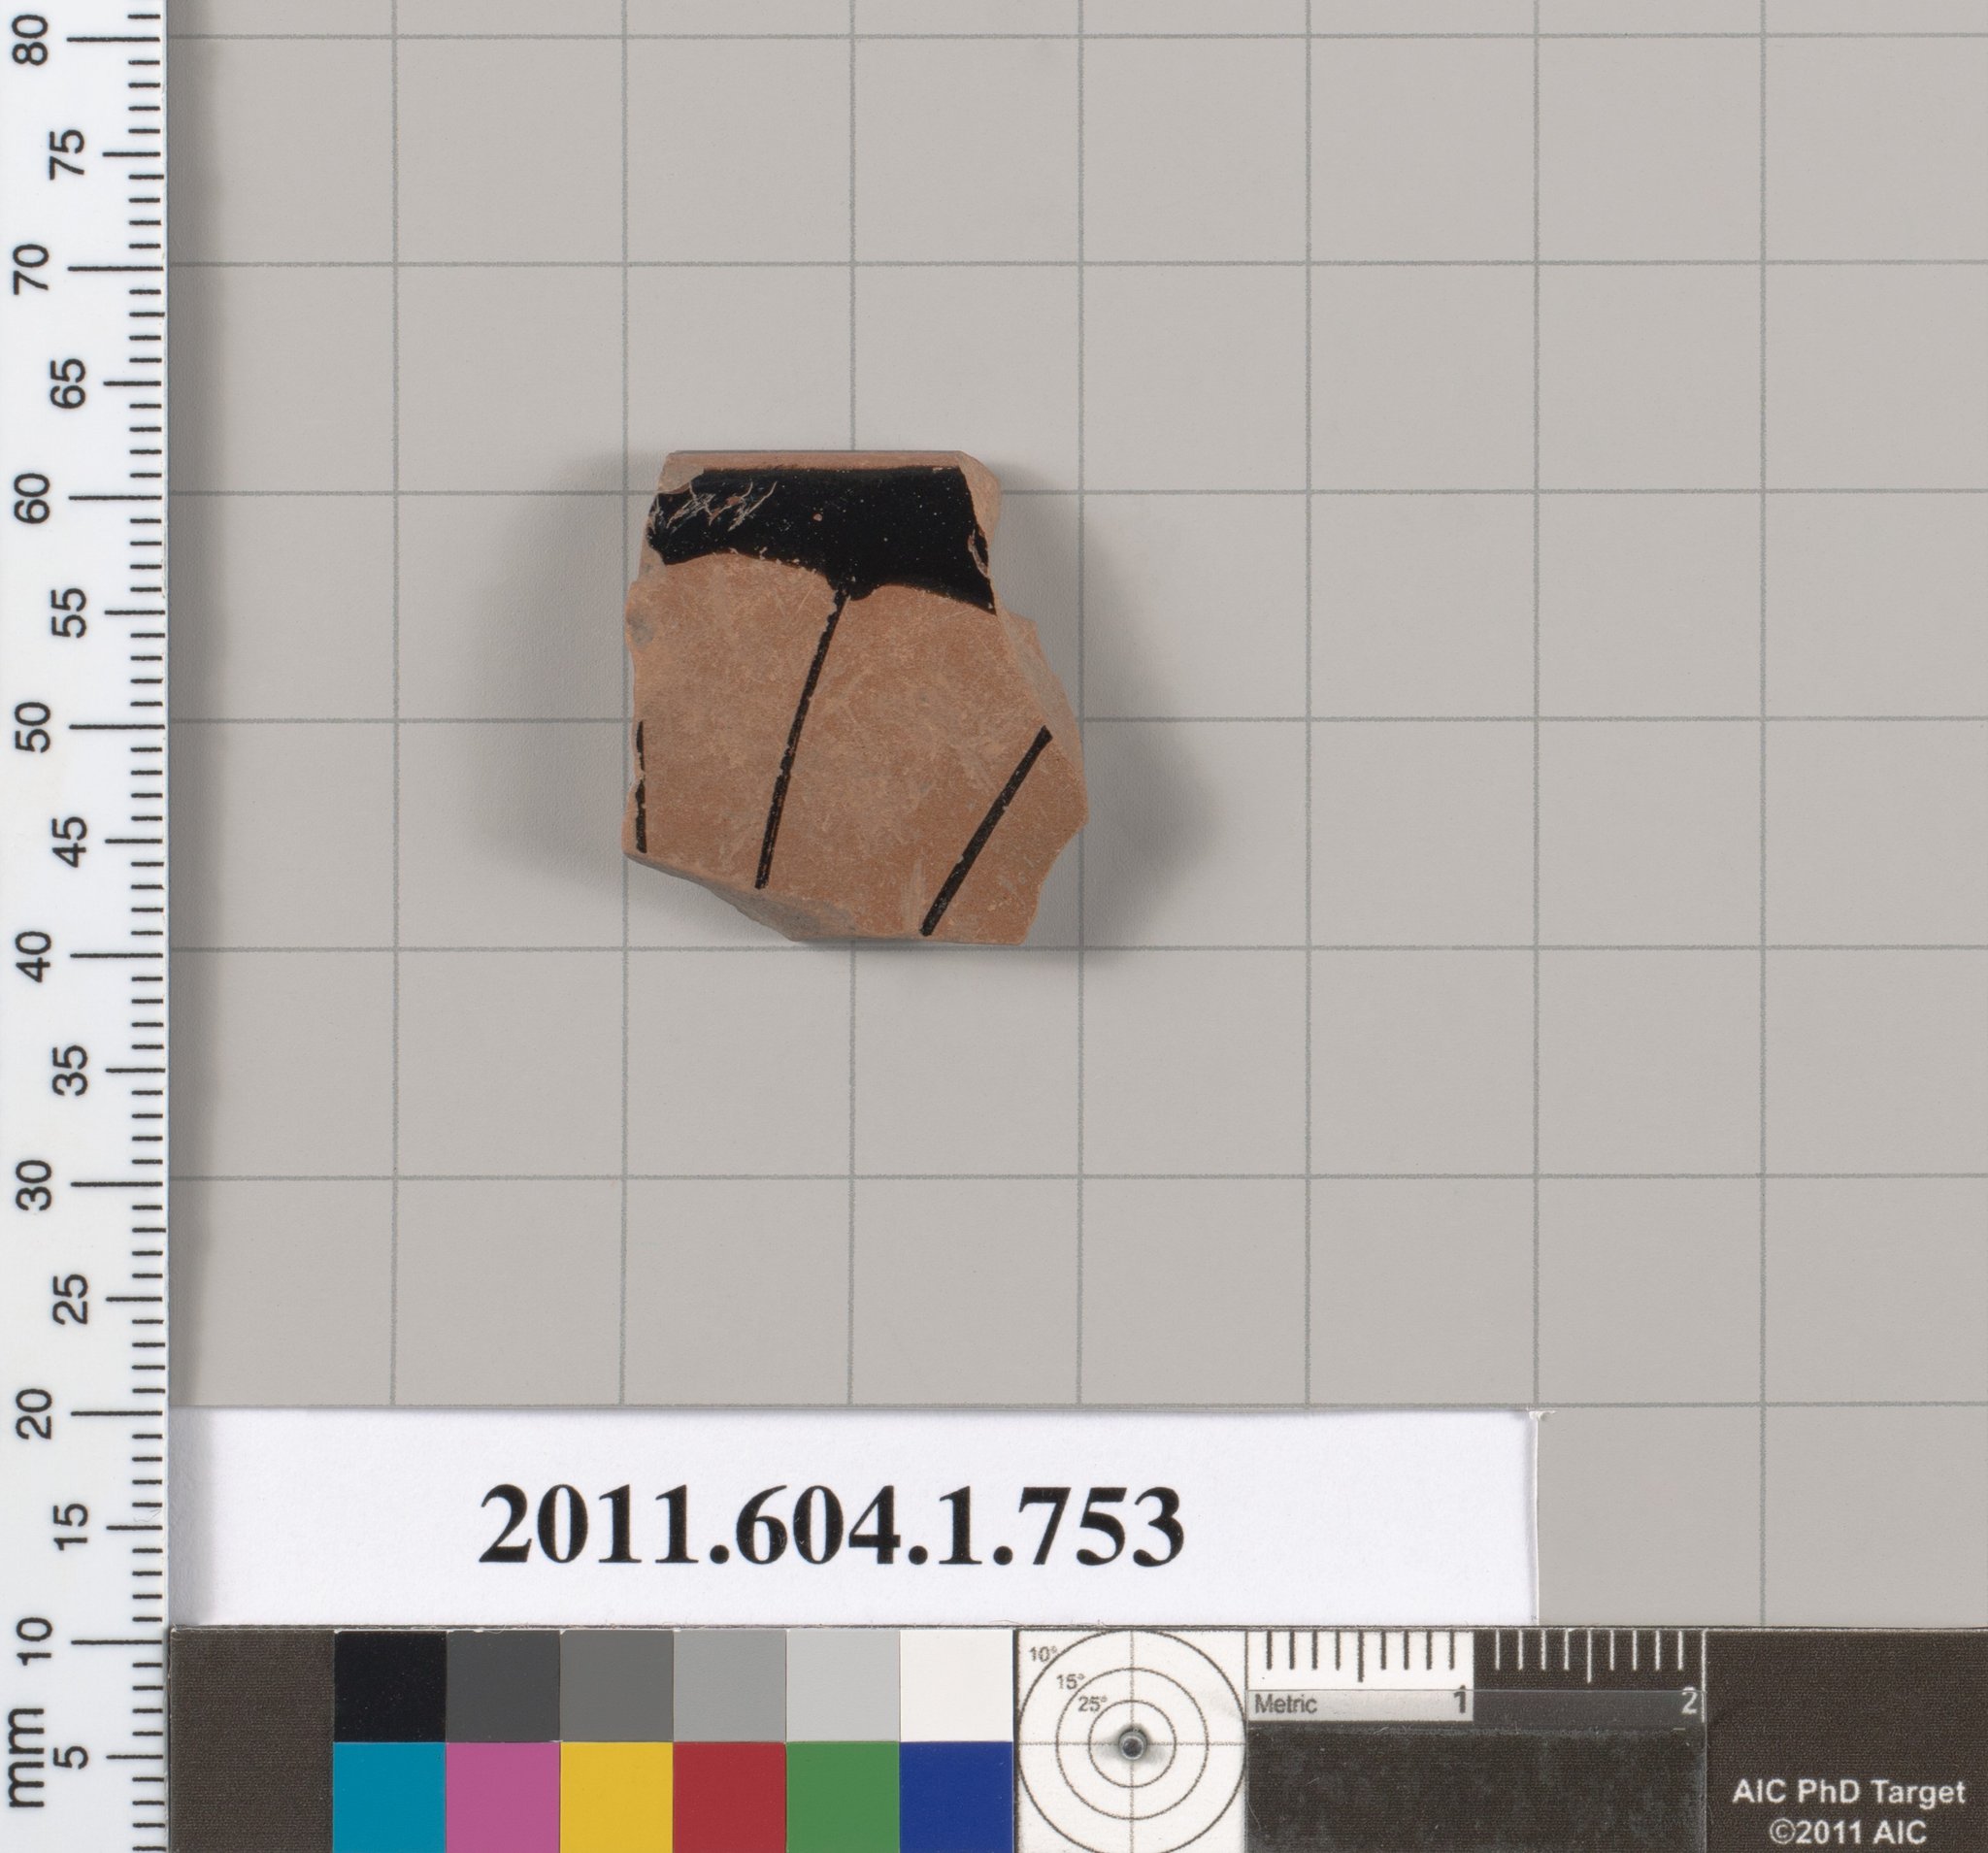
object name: kylix fragment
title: Terracotta rim fragment of a kylix (drinking cup)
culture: greek, attic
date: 520 BCE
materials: terracotta